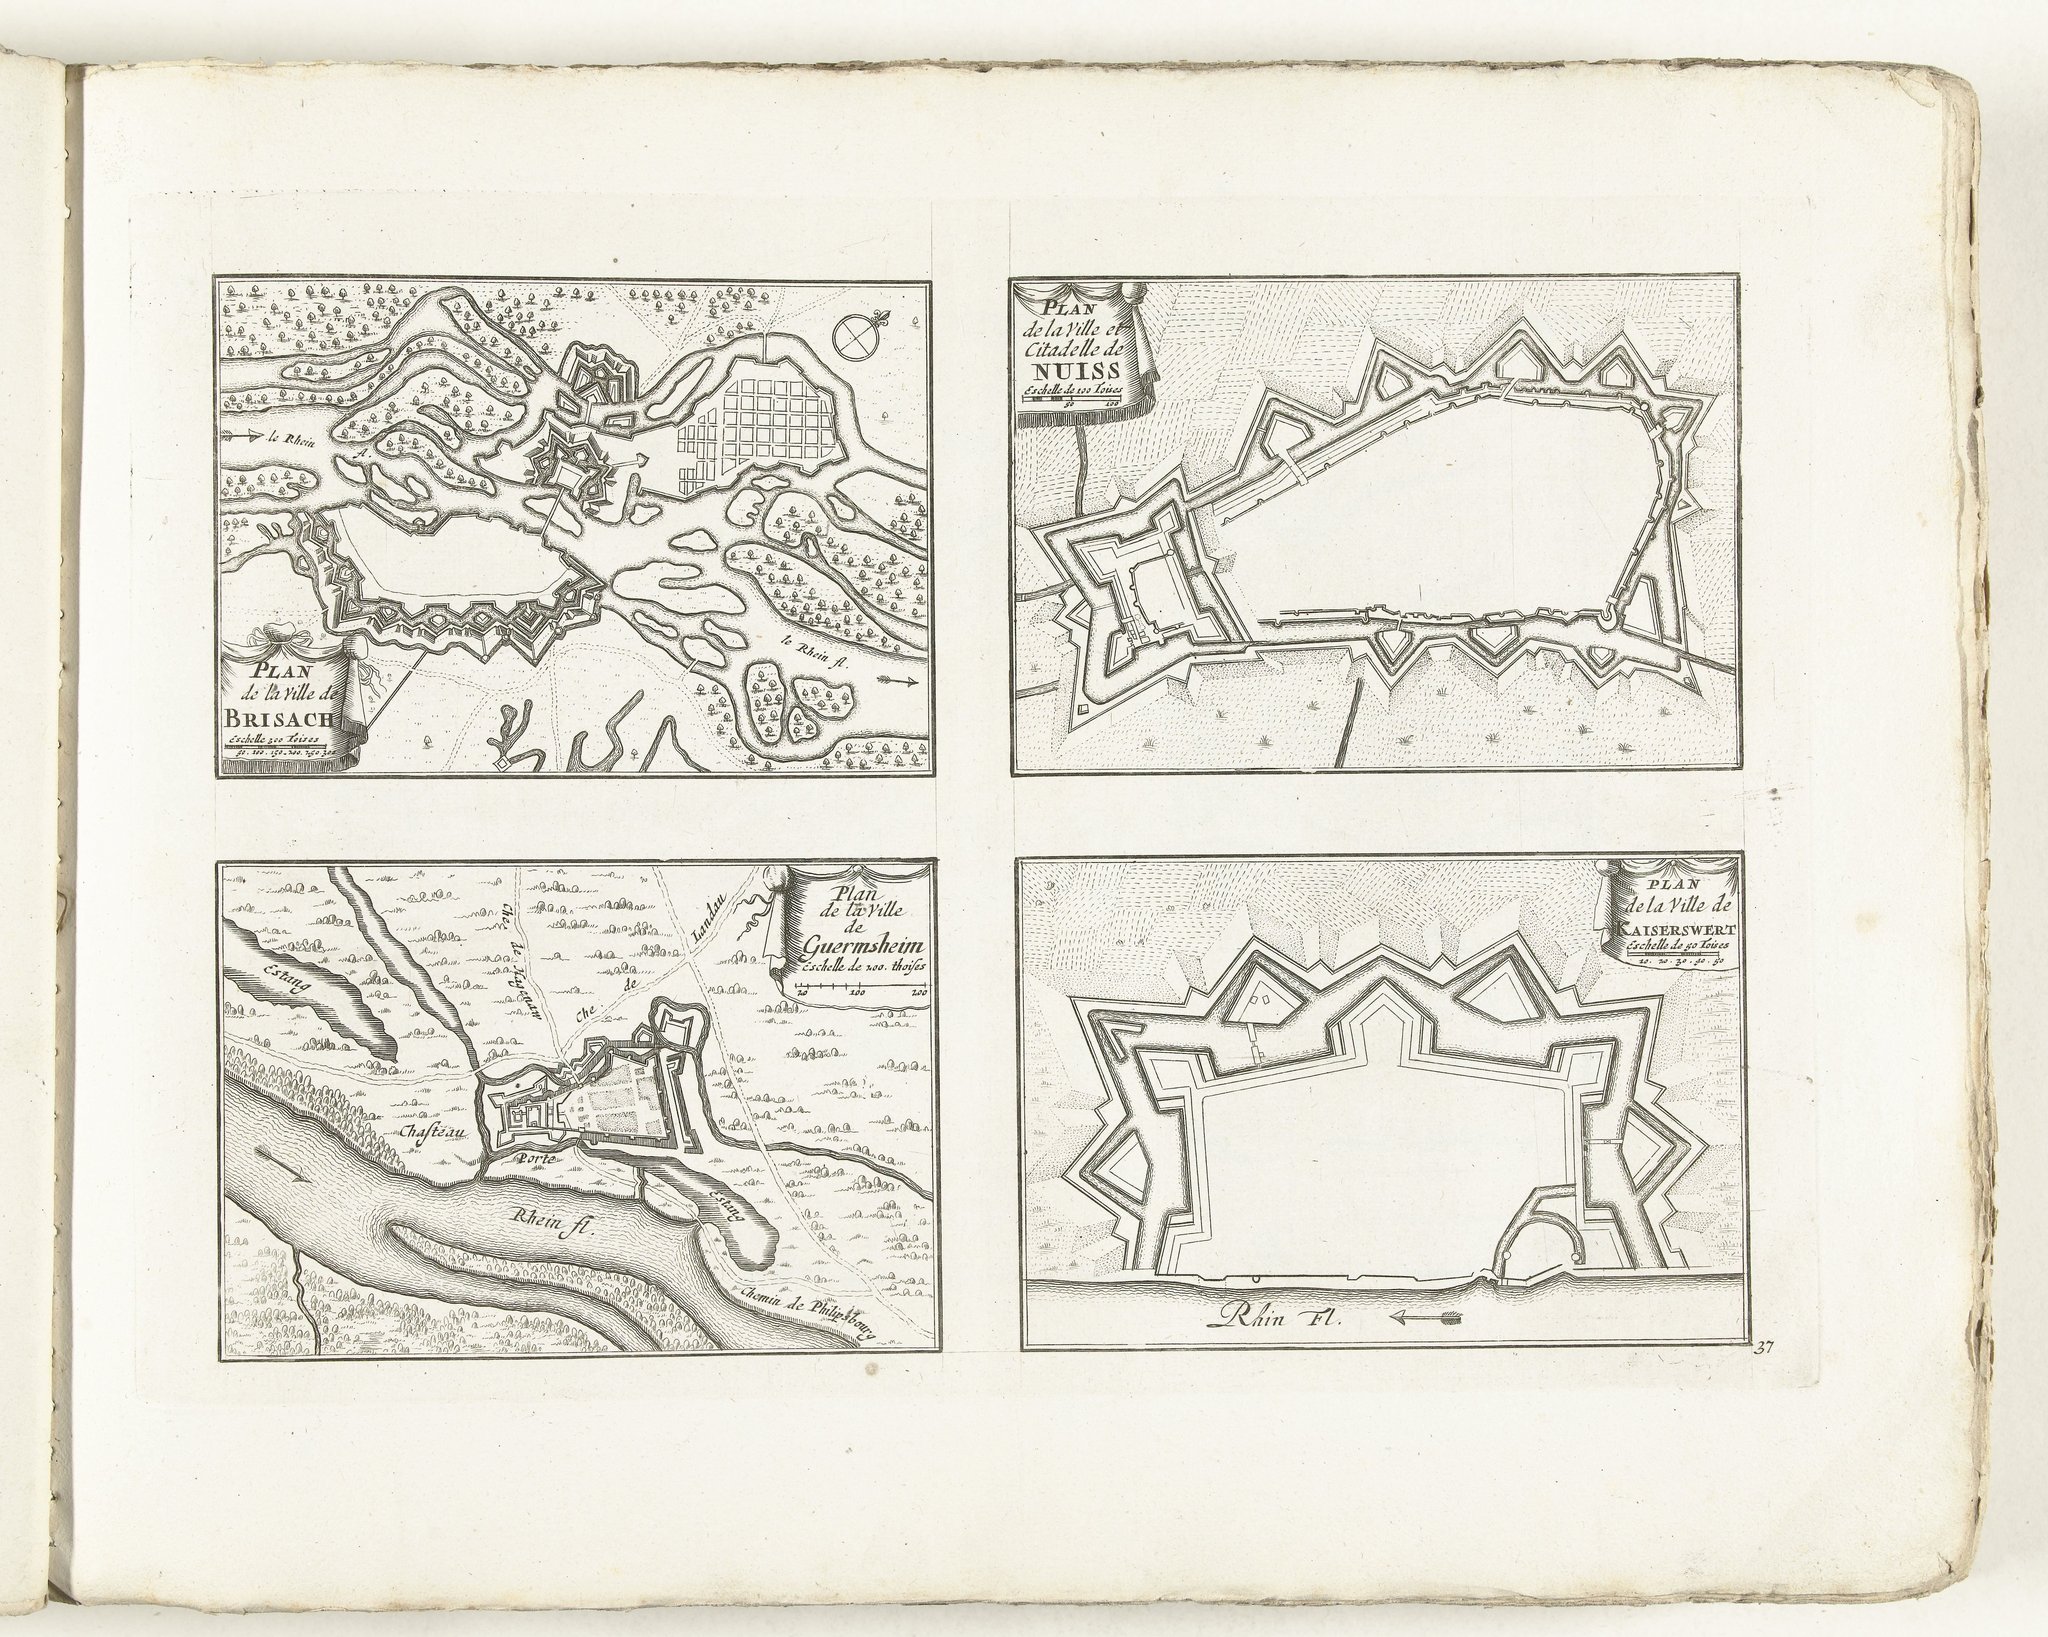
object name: print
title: Brisach / Nuiss / Guermsheim / Kaiserswerth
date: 1702-1703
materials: paper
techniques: etching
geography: northern netherlands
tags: fortress, maps of cities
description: Blad met vier plattegronden van de verdedigingswerken om de stad Breisach, Neuss, Germersheim en Kaiserswerth. Plaat nr. 37 in het prentwerk bestaande in totaal uit 276 genummerde platen van vermaarde sterke steden en vestingen in het kader van de Spaanse Successieoorlog. Voor het merendeel zijn deze platen gekopieerd naar de anonieme Franse platen: in Les forces de l'Europe en in: Le theatre de la guerre, dans les Pays-Bas, beide oorspronkelijk uitgegeven door Nicolas de Fer te Parijs (1693-1697) in het kader van de Negenjarige Oorlog. Titels en opschriften in de plaat in het Frans.